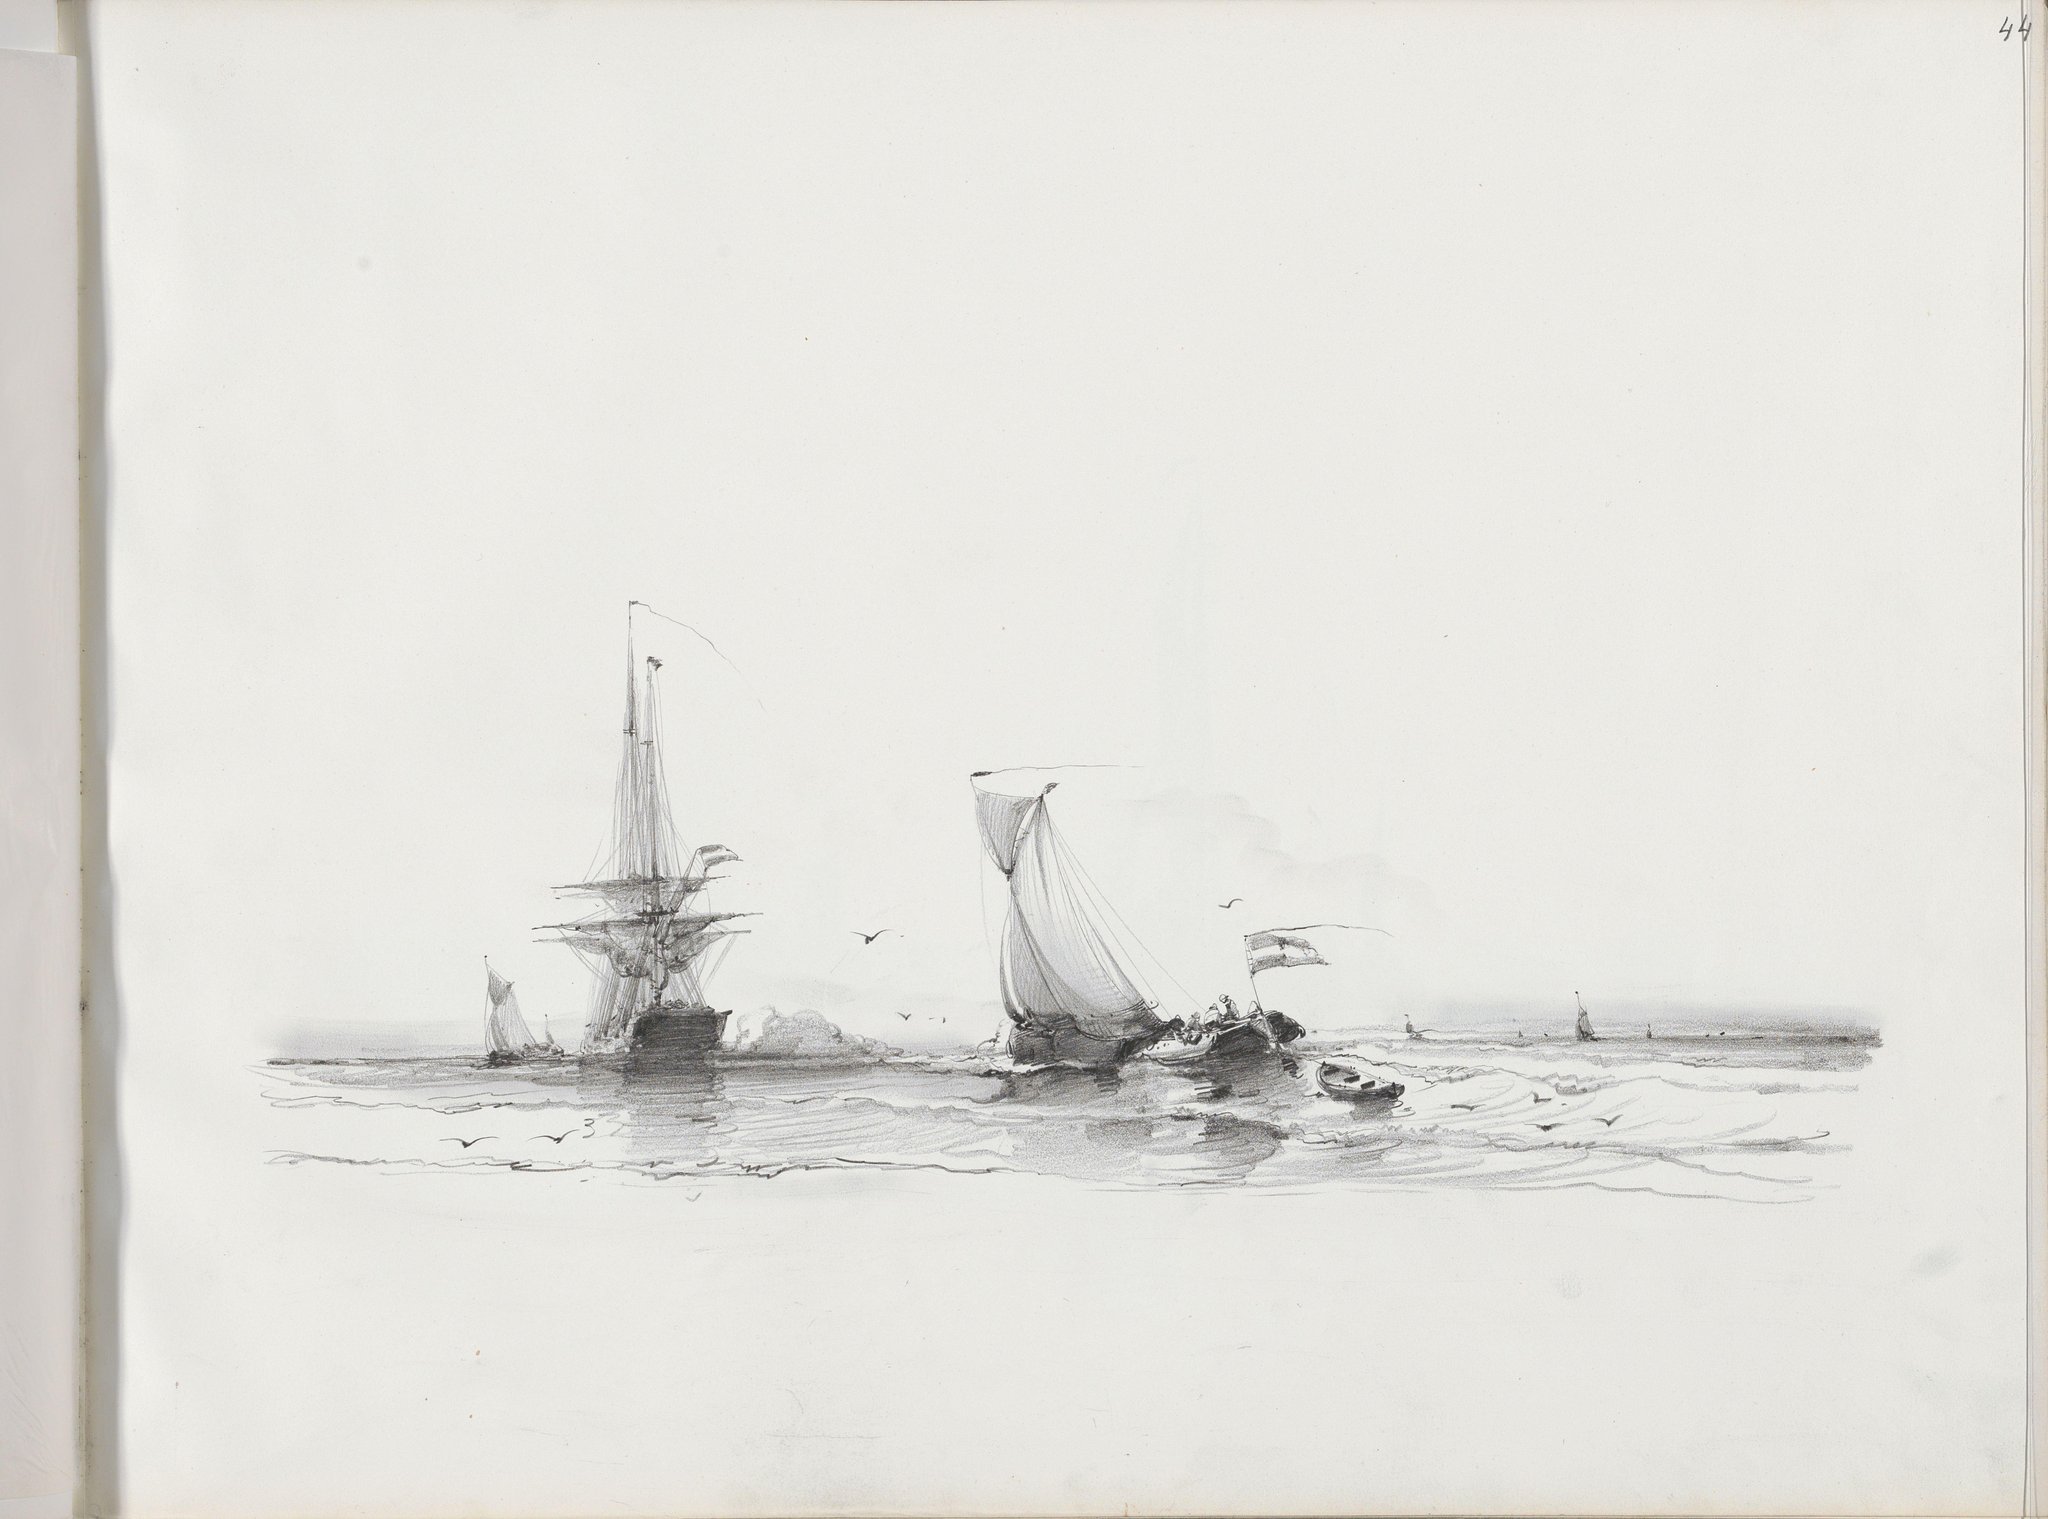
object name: sketchbook leaf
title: Zeilboten en -schepen op het water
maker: albertus van beest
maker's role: draughtsman, print maker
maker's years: 1820-1860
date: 1830-1860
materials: paper, pencil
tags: sailing-ship, sailing-boat, landscapes with waters, waterscapes, seascapes (in the temperate zone)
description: Blad 44 recto uit een schetsboek met 46 bladen.